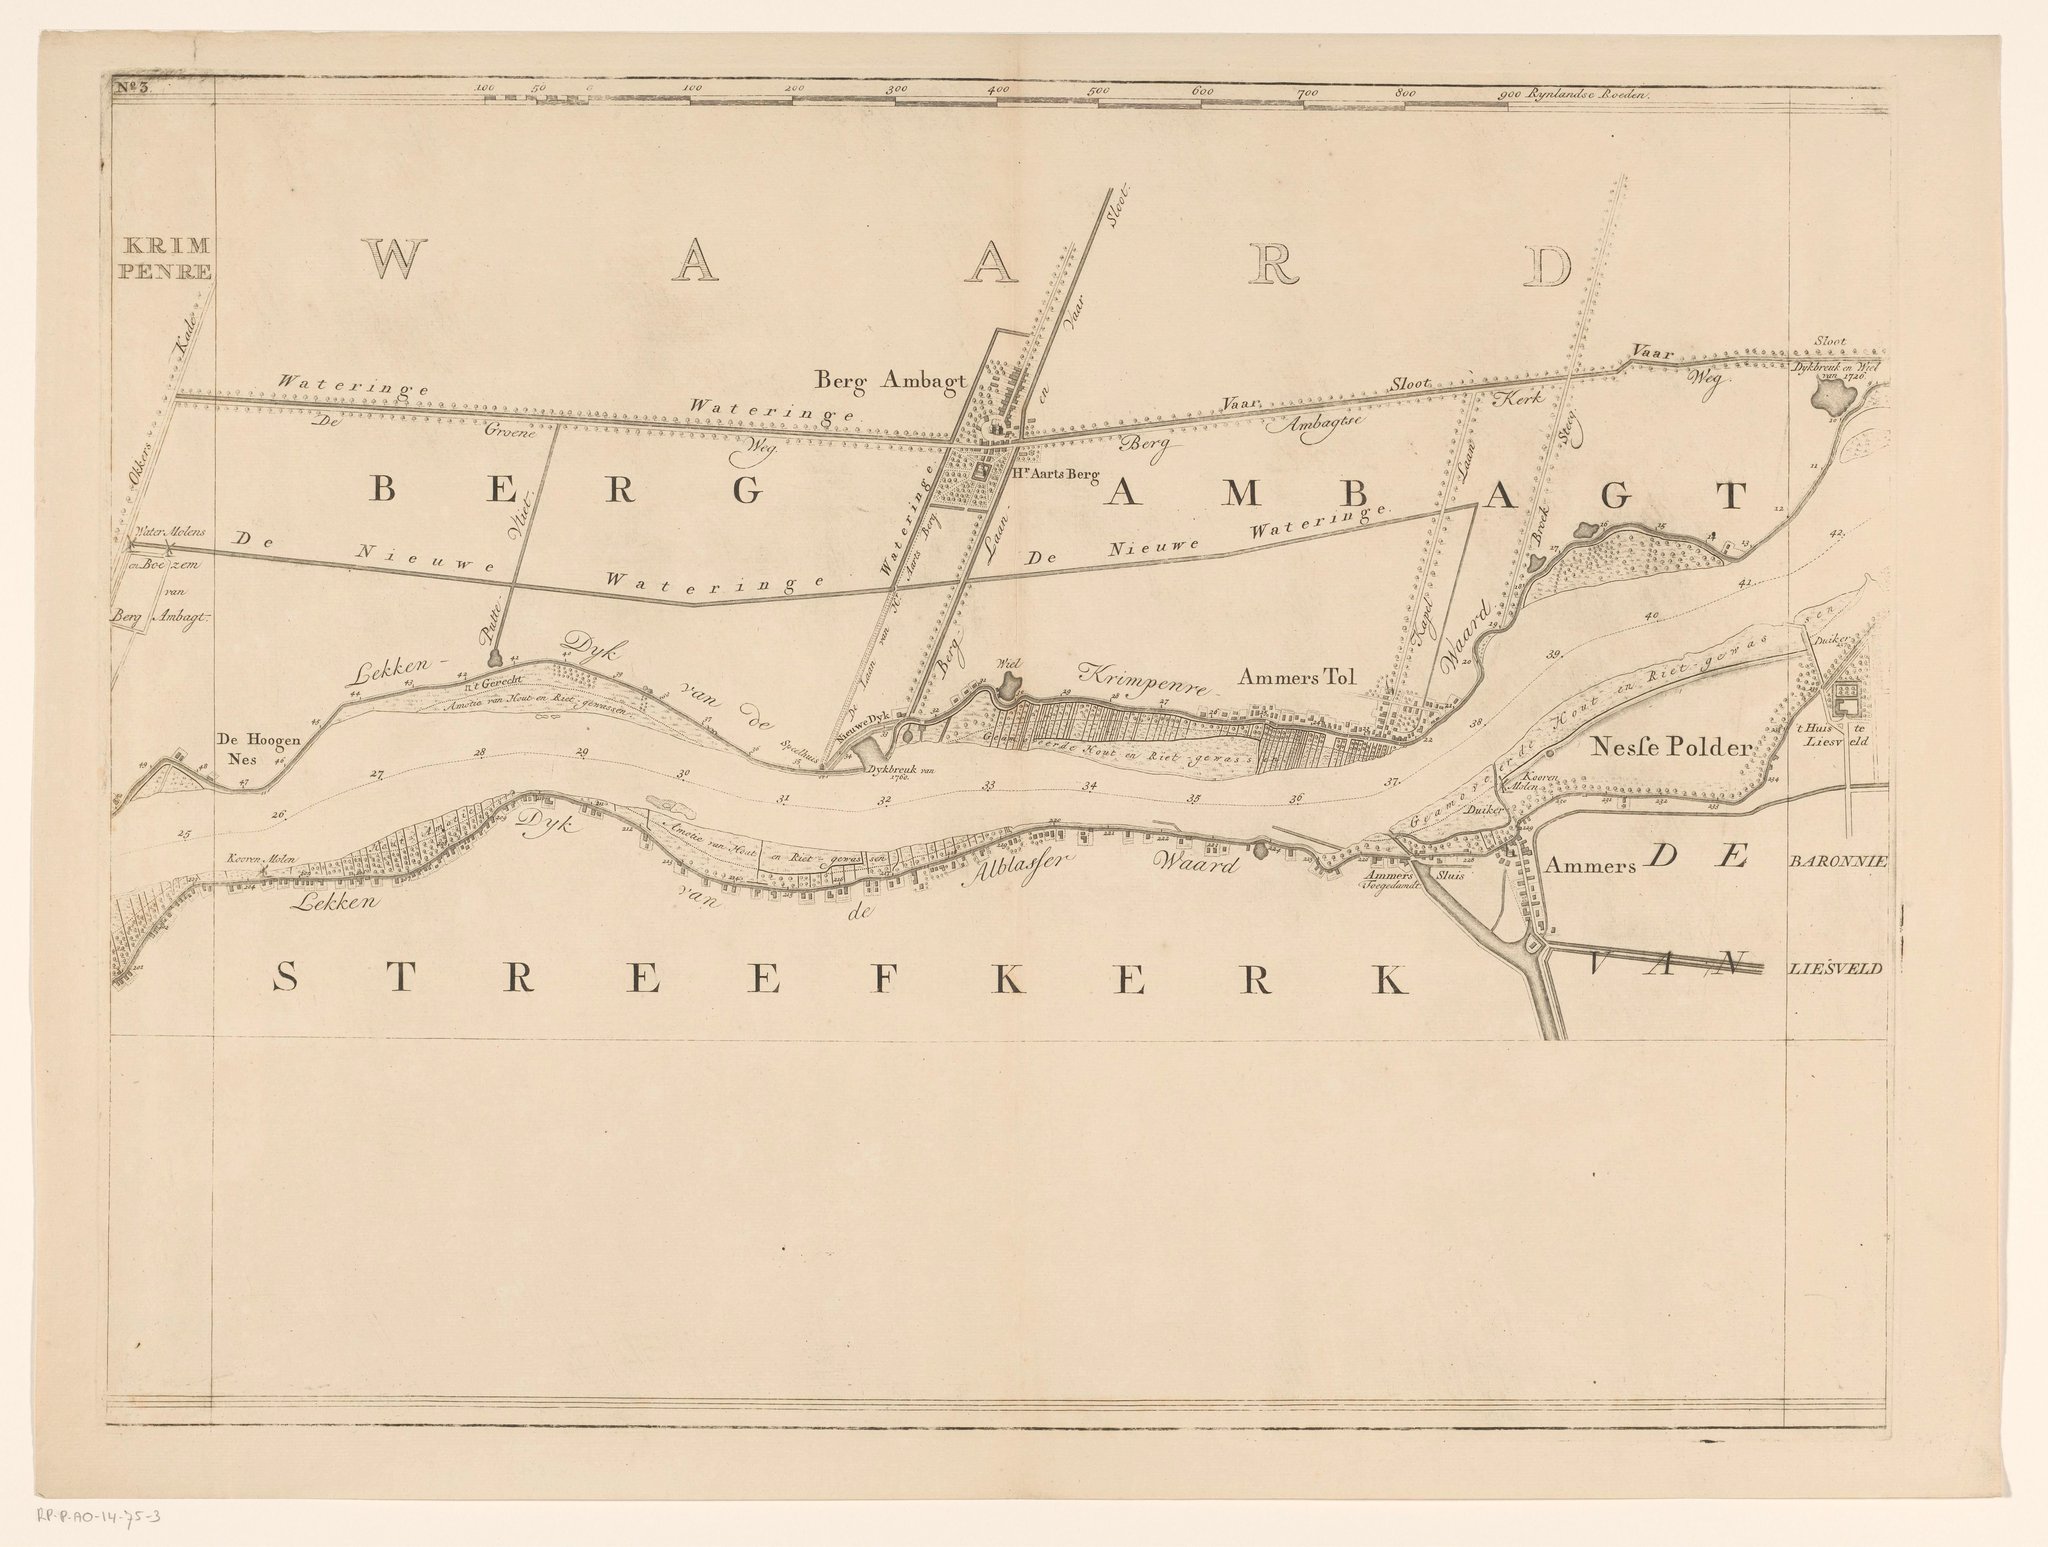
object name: print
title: Kaart van de rivier de Lek (derde deel)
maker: isaak tirion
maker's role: publisher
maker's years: 1705-1765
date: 1764-1765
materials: paper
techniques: engraving, etching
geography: amsterdam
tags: maps of separate countries or regions, river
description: Derde deel van een kaart van de rivier de Lek, bestaande uit zeven delen. Linksboven genummerd: No. 3.